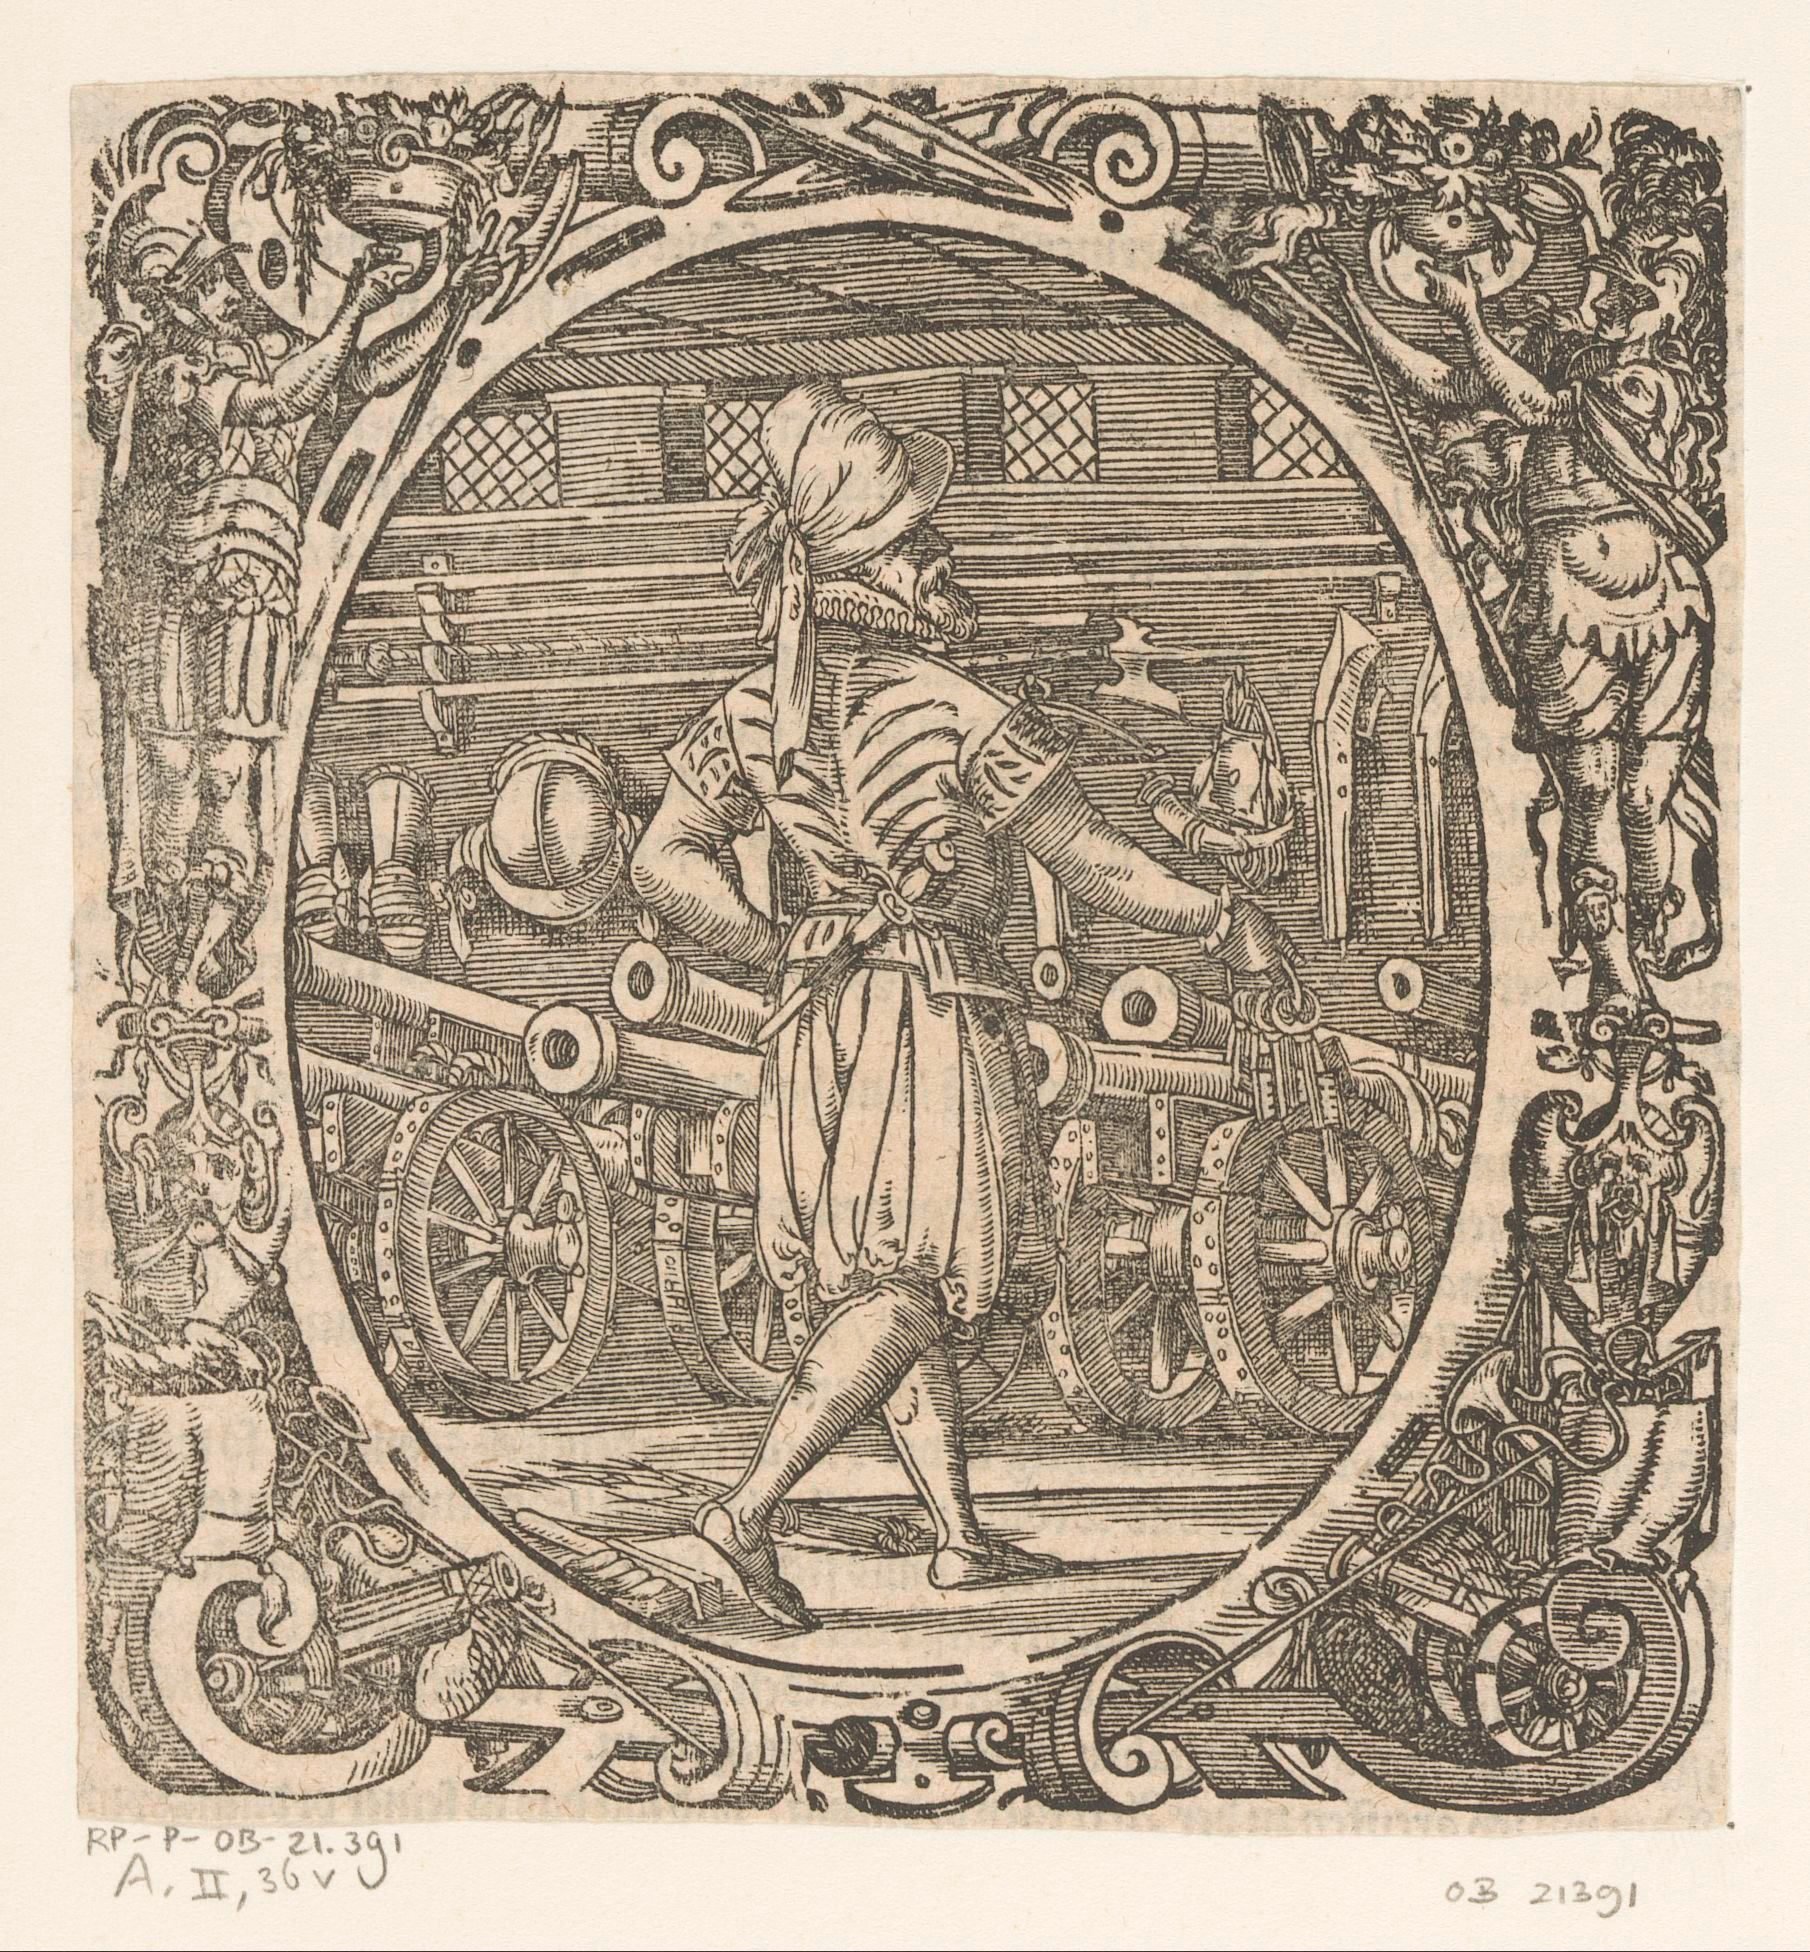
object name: book illustration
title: Commandant in het arsenaal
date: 1573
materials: paper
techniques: woodcut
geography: nuremberg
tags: commander-in-chief, general, marshal, warfare; military affairs, ammunition store, arsenal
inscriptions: collector's mark: Lugt 240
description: Zowel de voorstelling als de ornamentrand werd gebruikt voor verschillende edities van Leonhardt Fronspergers Kriegsbuch.